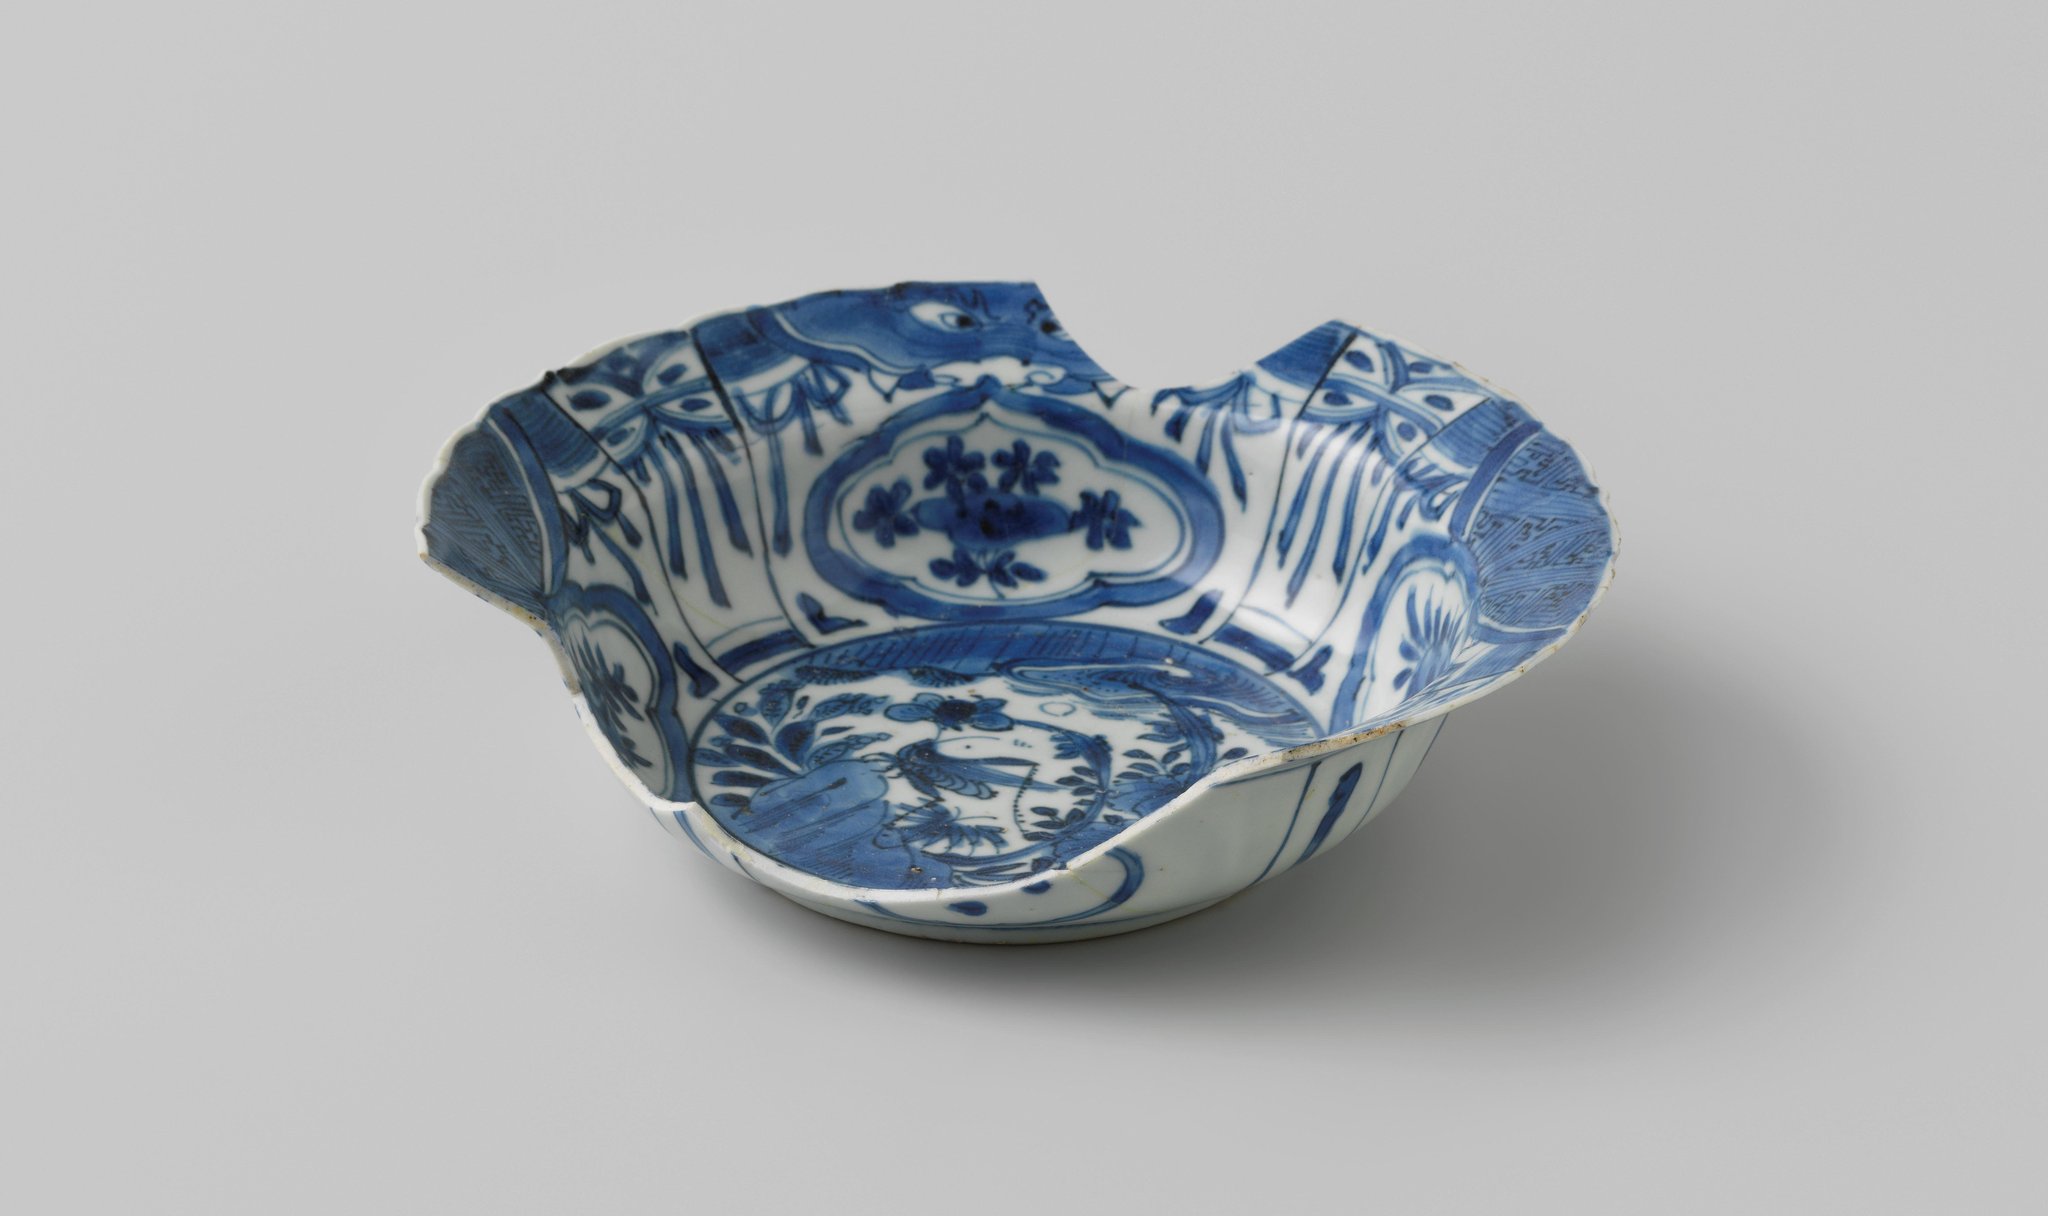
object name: sherd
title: Shallow bowl or 'klapmuts' of Chinese porcelain from the wreck of the Dutch East Indiaman Witte Leeuw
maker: Anonymous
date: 1613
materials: bone china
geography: jingdezhen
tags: verenigde oostindische compagnie, sint-helena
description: A bowl with a flattened rim. Taotie mask and/or borders with diaper patterns. A central decoration of a flying cicada and a grasshopper on a rock next to flowers. Panels decorated with flowers and fruits.